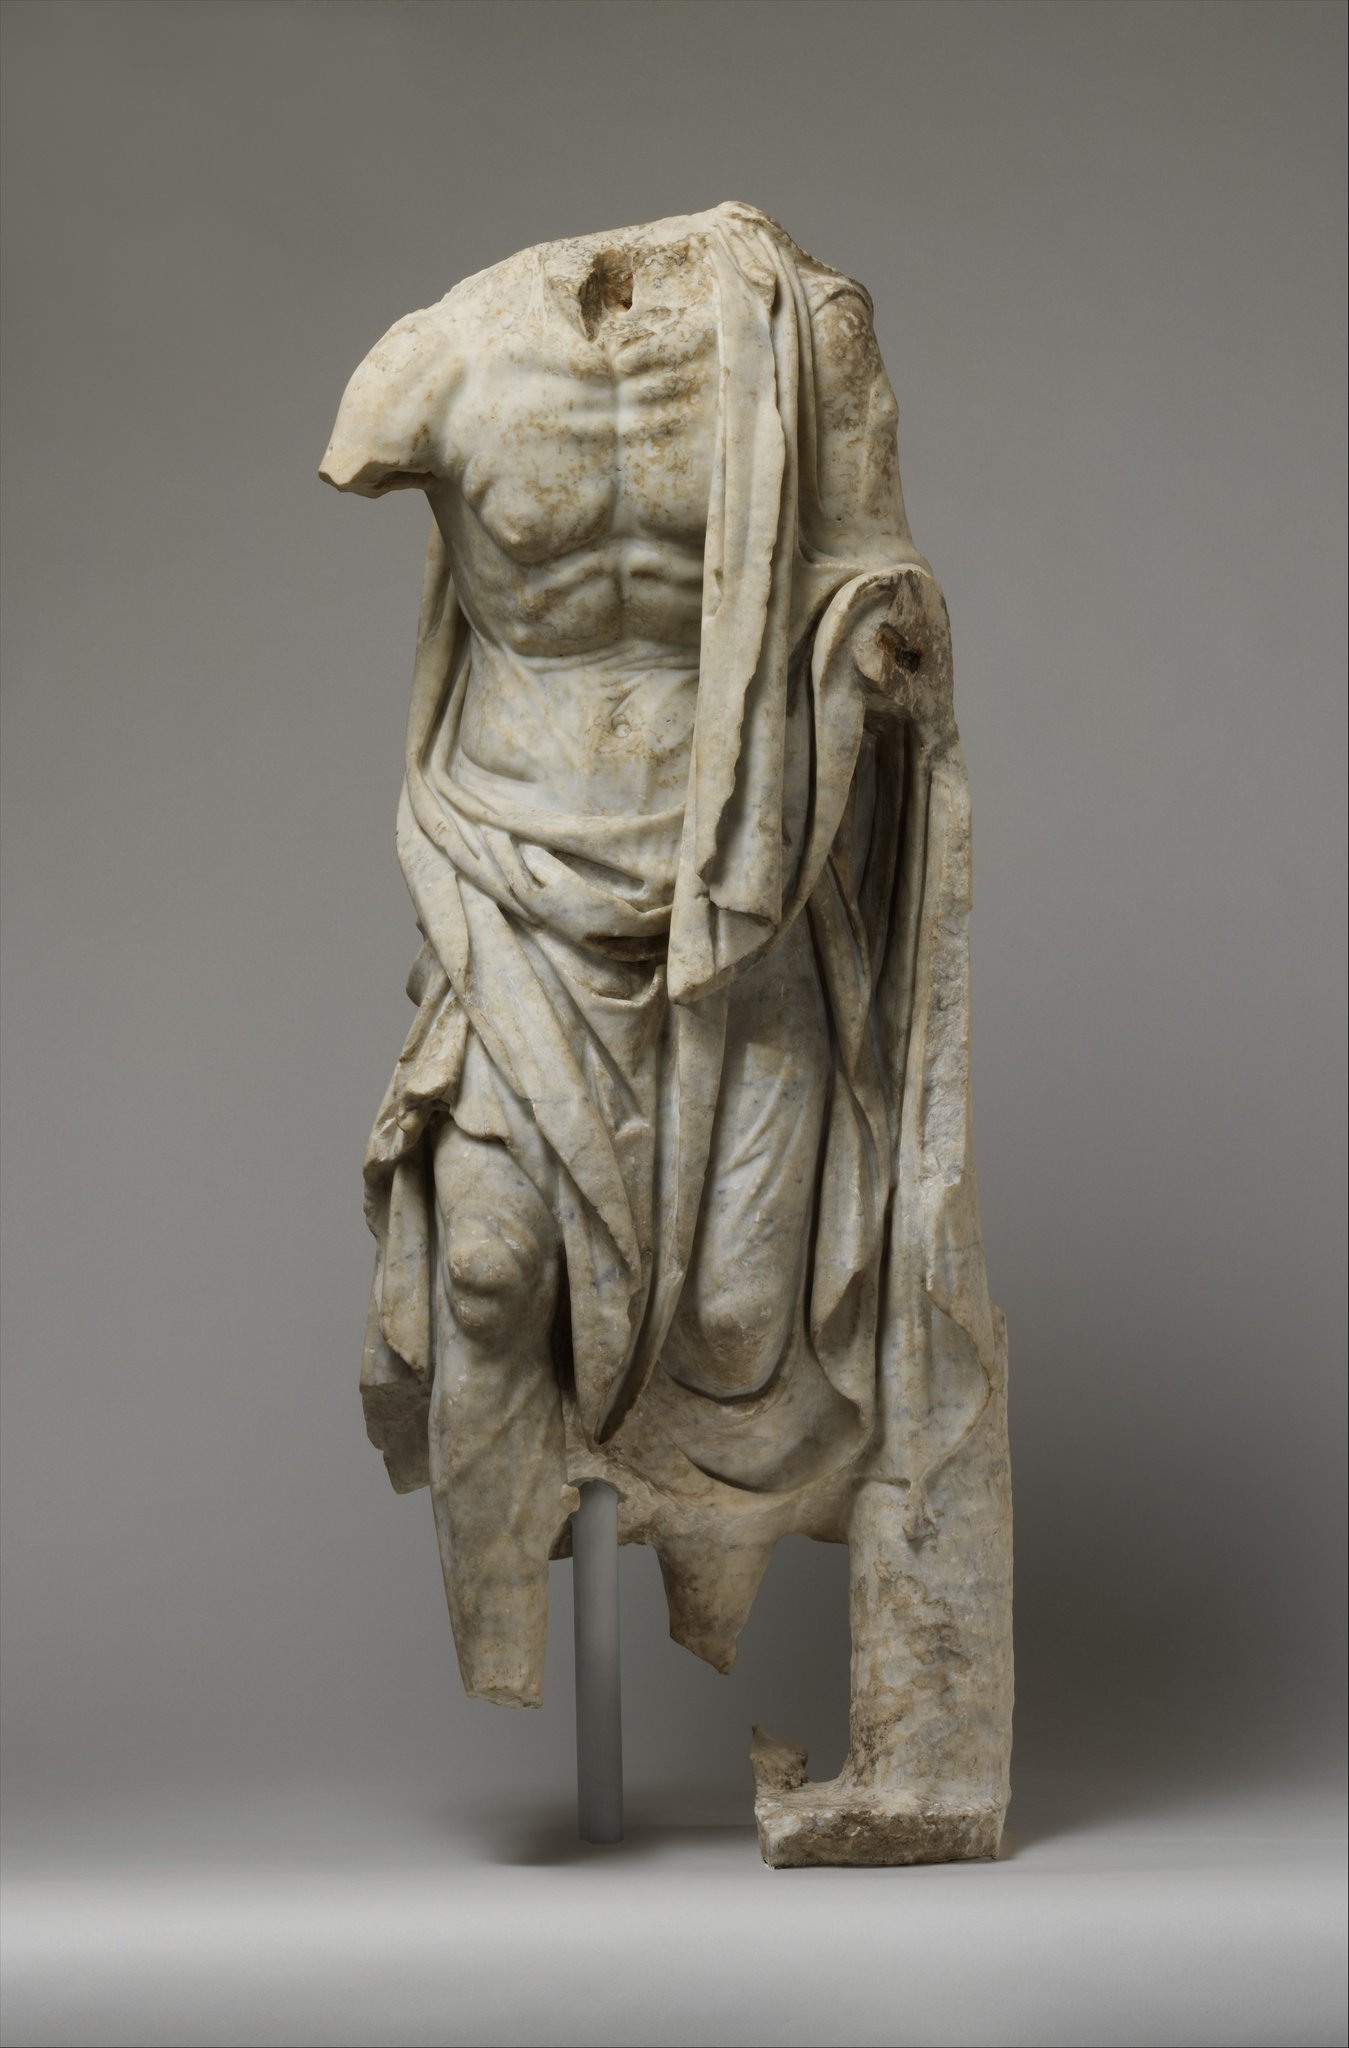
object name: statue of an old fisherman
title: Marble statue of an old fisherman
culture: roman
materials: marble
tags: men